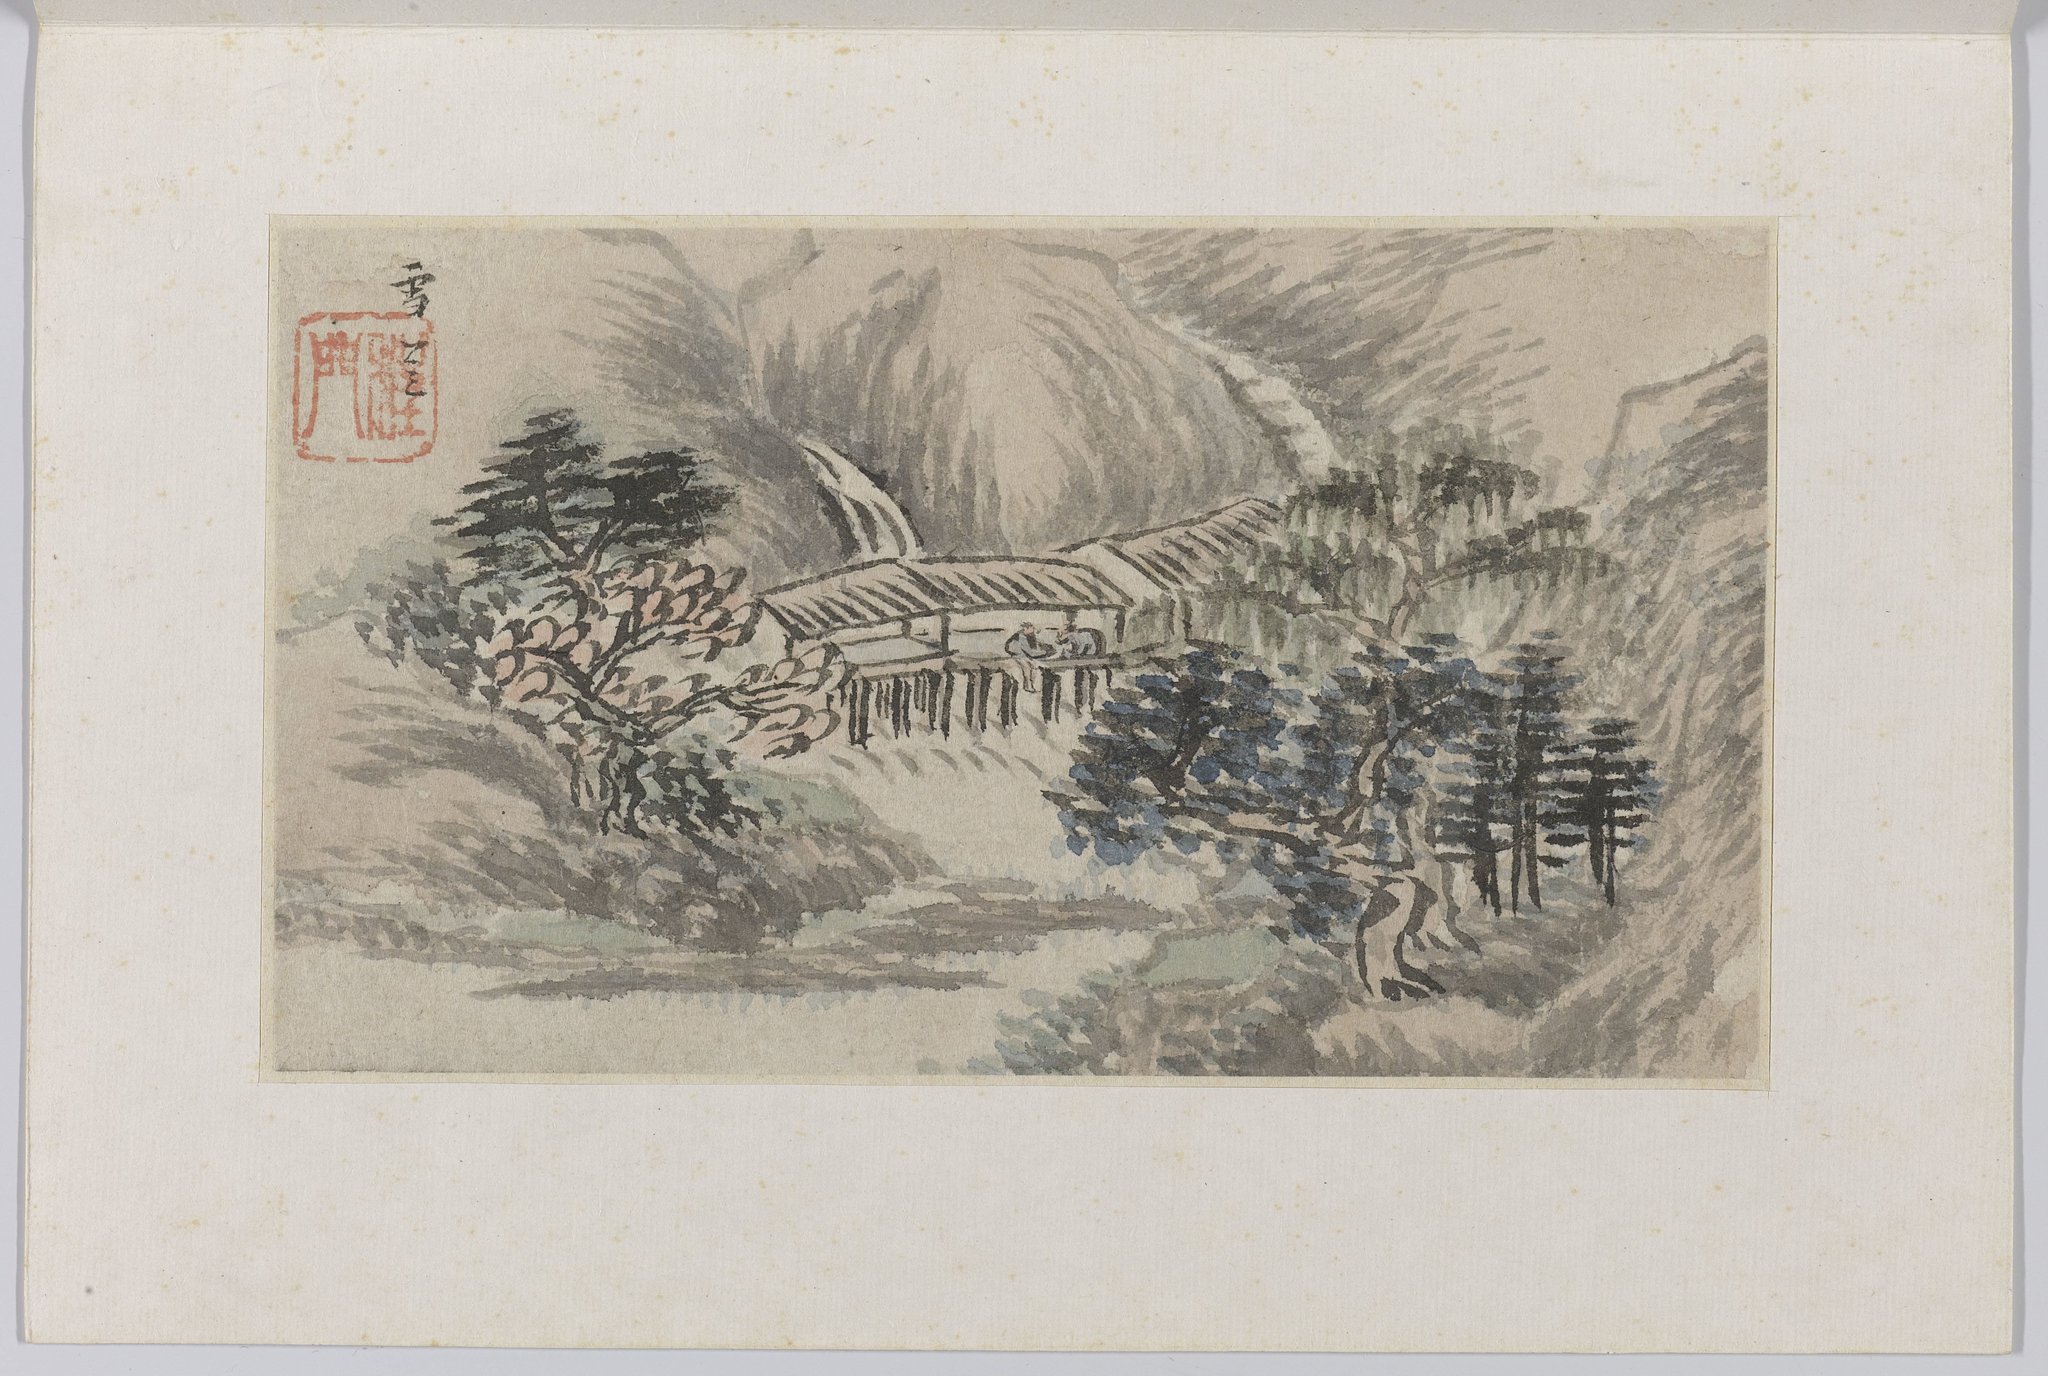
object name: painting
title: Landschap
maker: cheng men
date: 1850-1900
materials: ink, paper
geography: shexian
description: Albumblad met een landschap. Gesigneerd door Cheng Men, bekend als porseleinschilder in Jingdezhen.